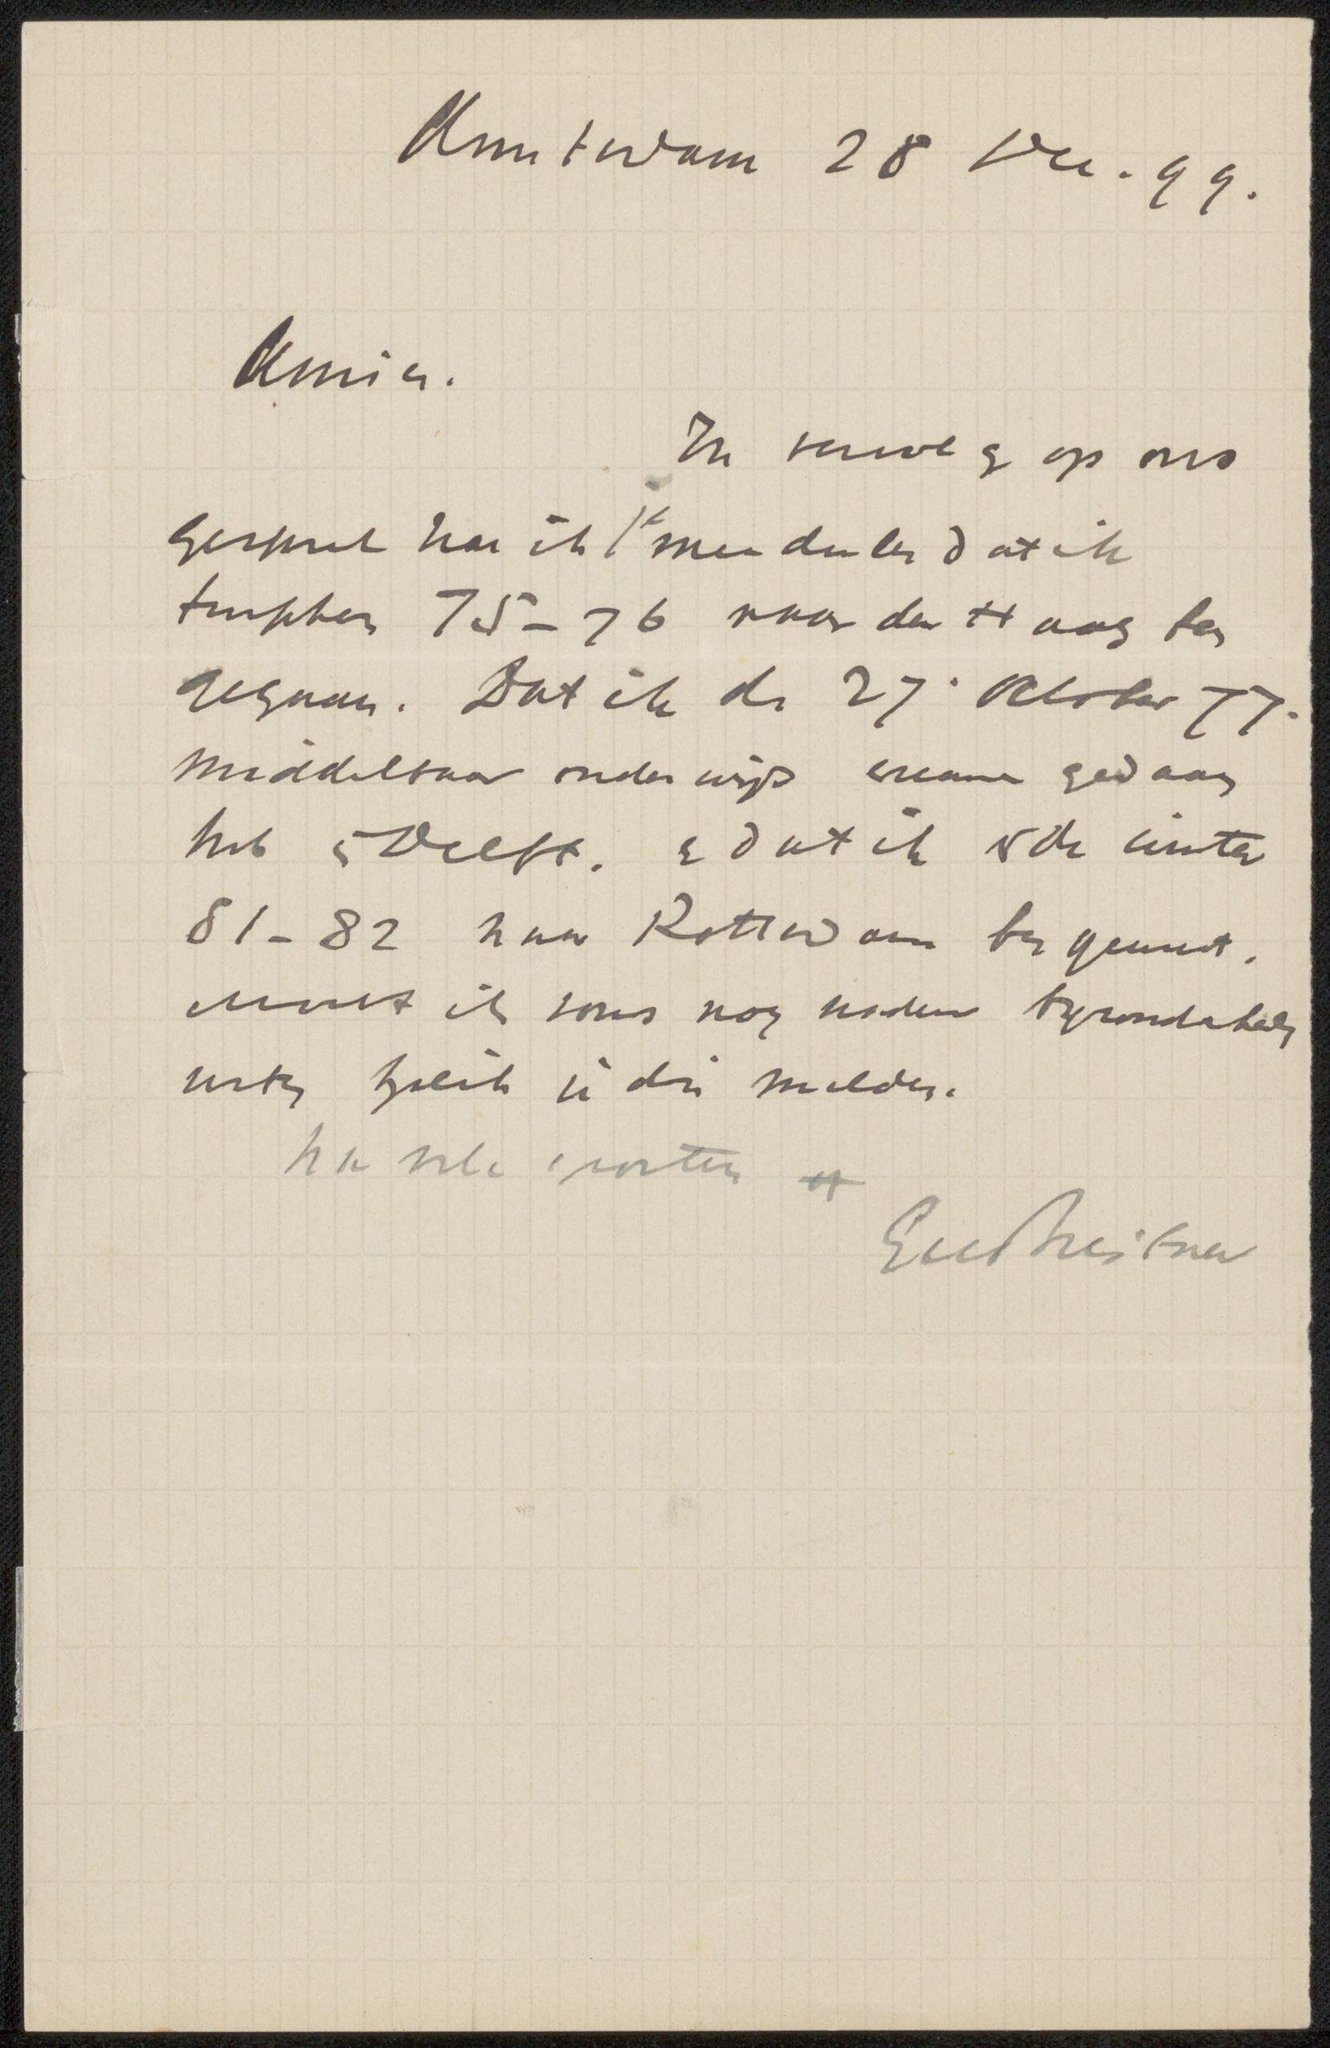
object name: letter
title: Brief aan Jan Veth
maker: george hendrik breitner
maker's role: draughtsman, painter, print maker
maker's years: 1857-1923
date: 1899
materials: ink, paper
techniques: pen, writing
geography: amsterdam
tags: dordrecht, designer, jan veth, the hague, delft, rotterdam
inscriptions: collector's mark: ‘RPK’